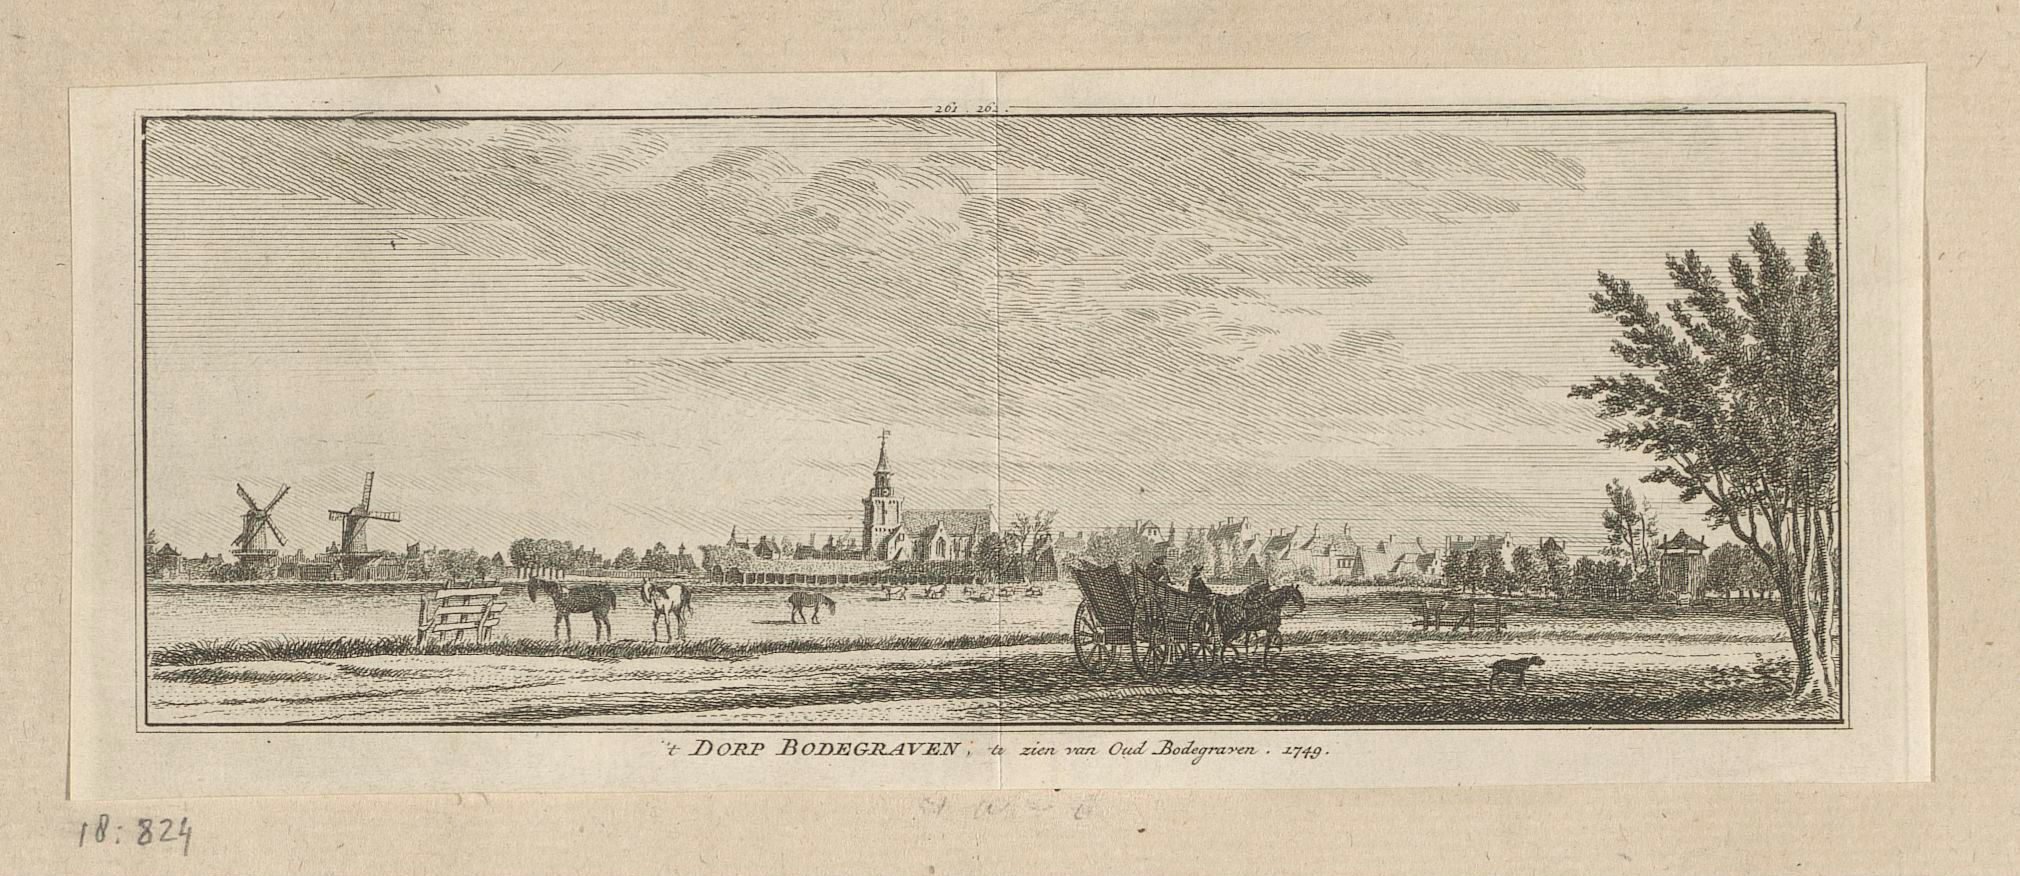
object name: book illustration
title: 't Dorp Bodegraven, te zien van Oud Bodegraven. 1749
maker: hendrik spilman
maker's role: draughtsman, painter, print maker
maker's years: 1721-1784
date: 1750-1792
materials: paper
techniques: engraving, etching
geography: haarlem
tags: prospect of village, silhouette of village, church (exterior), windmill, bodegraven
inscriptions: collector's mark: Lugt 2228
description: Prent ook gebruikt in: Het verheerlykt Nederland of kabinet van hedendaagsche gezigten van steden, dorpen (…). 9 delen. Amsterdam: Isaak Tirion en weduwe Isaak Tirion, 1745-1774, dl. 3 (1750), ill. 261-262. Of in: Nederlandsche tafereelen; of eene keurige verzameling van negen honderd fraaije gezigten van steden, dorpen, sloten, oudheden (….). 9 delen. Amsterdam: Jan de Groot, 1792, dl. 3, ill. 261-262.